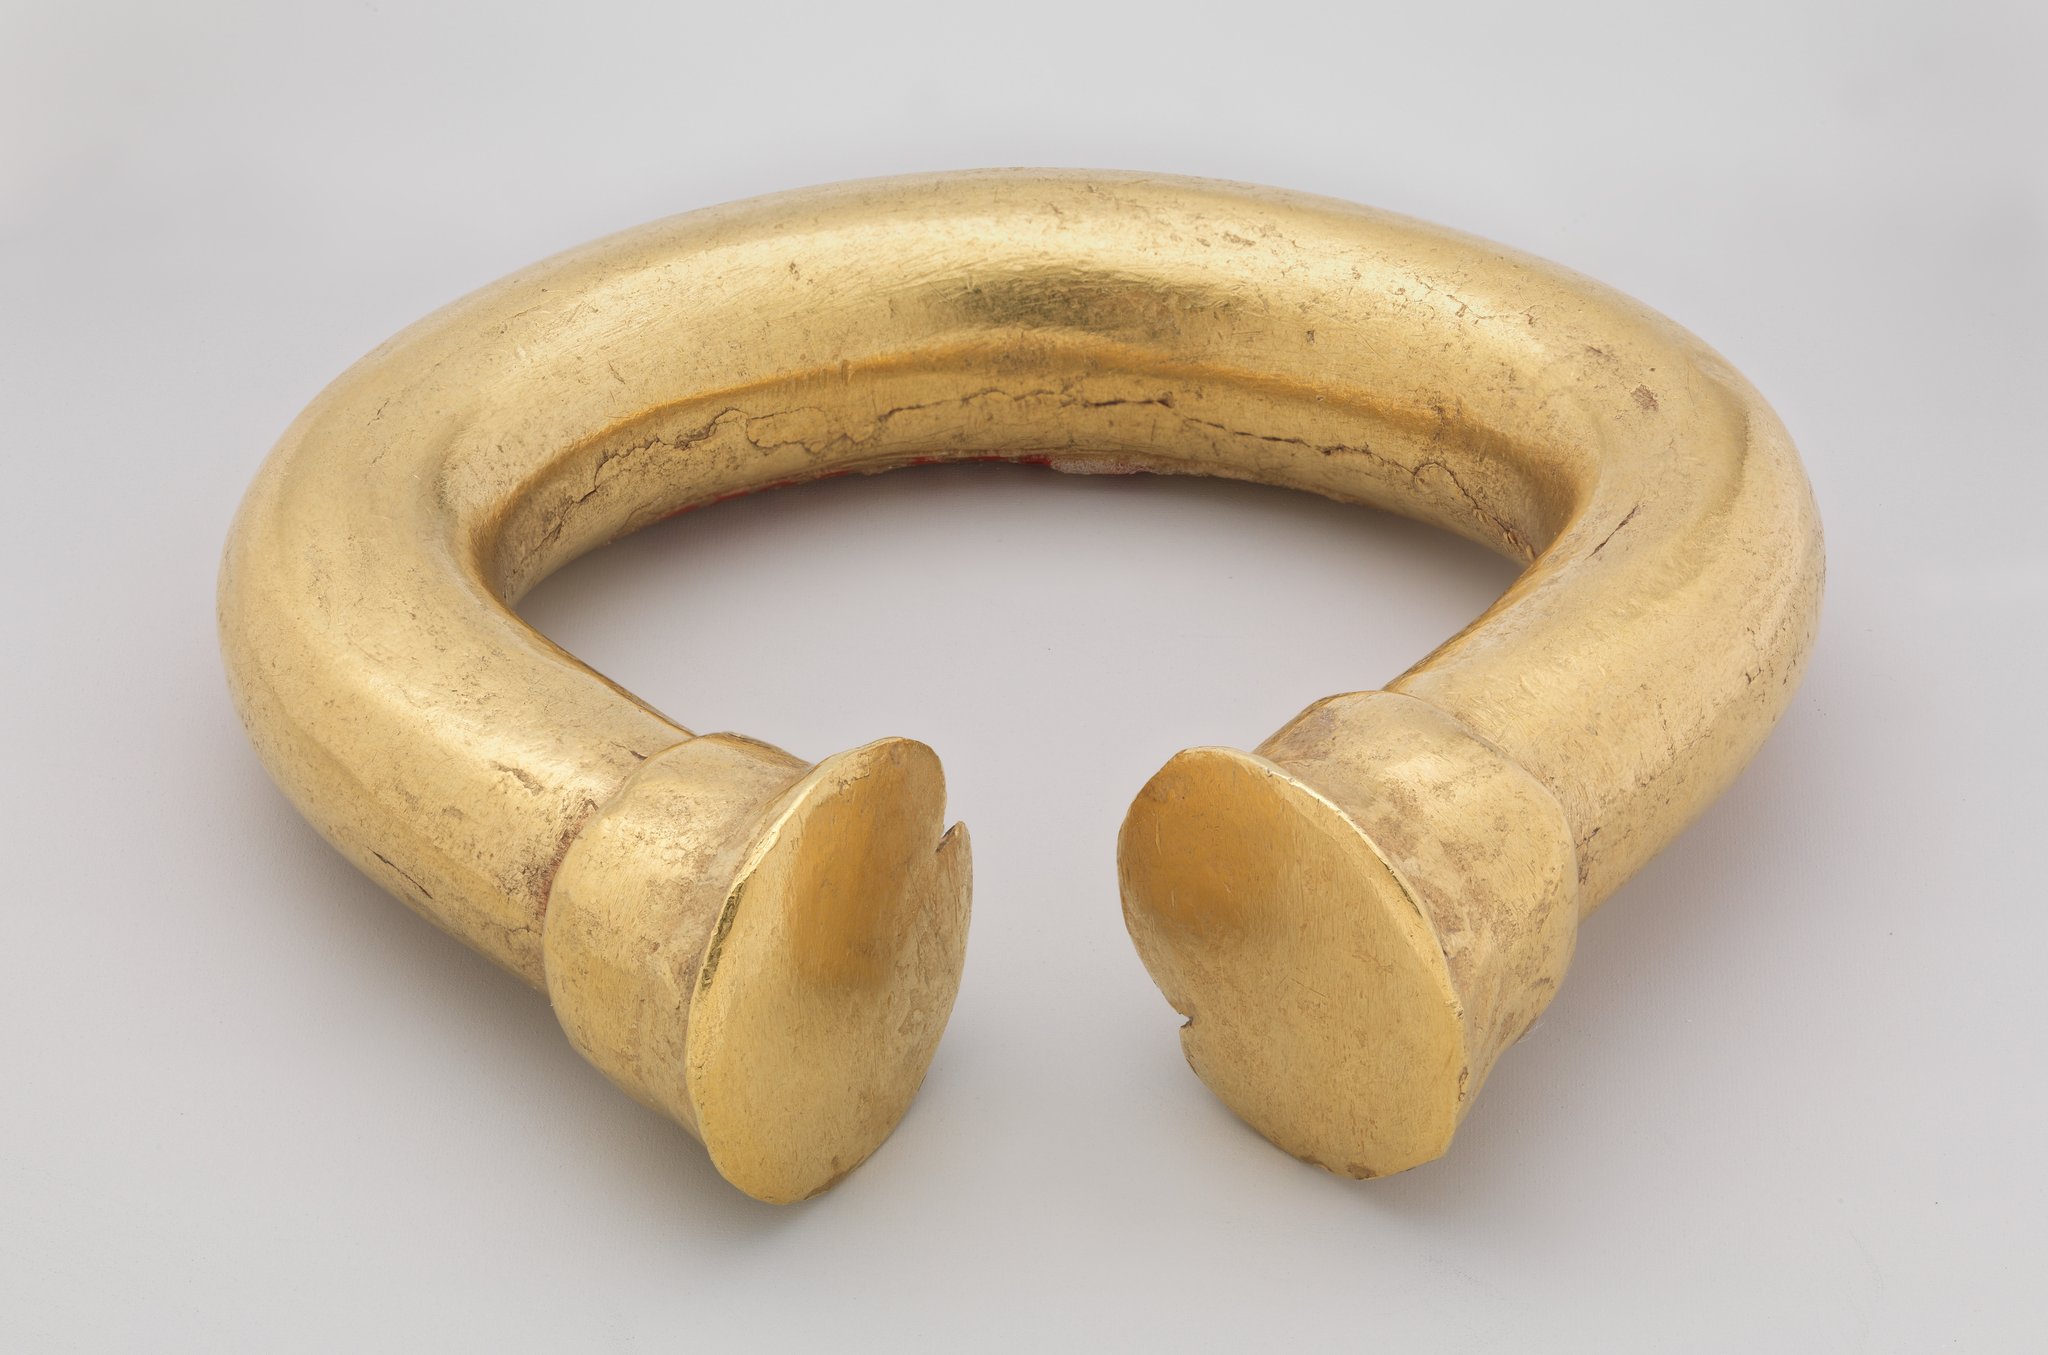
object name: ornament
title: Nose Ornament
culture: zenú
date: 1-1000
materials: gold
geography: colombia